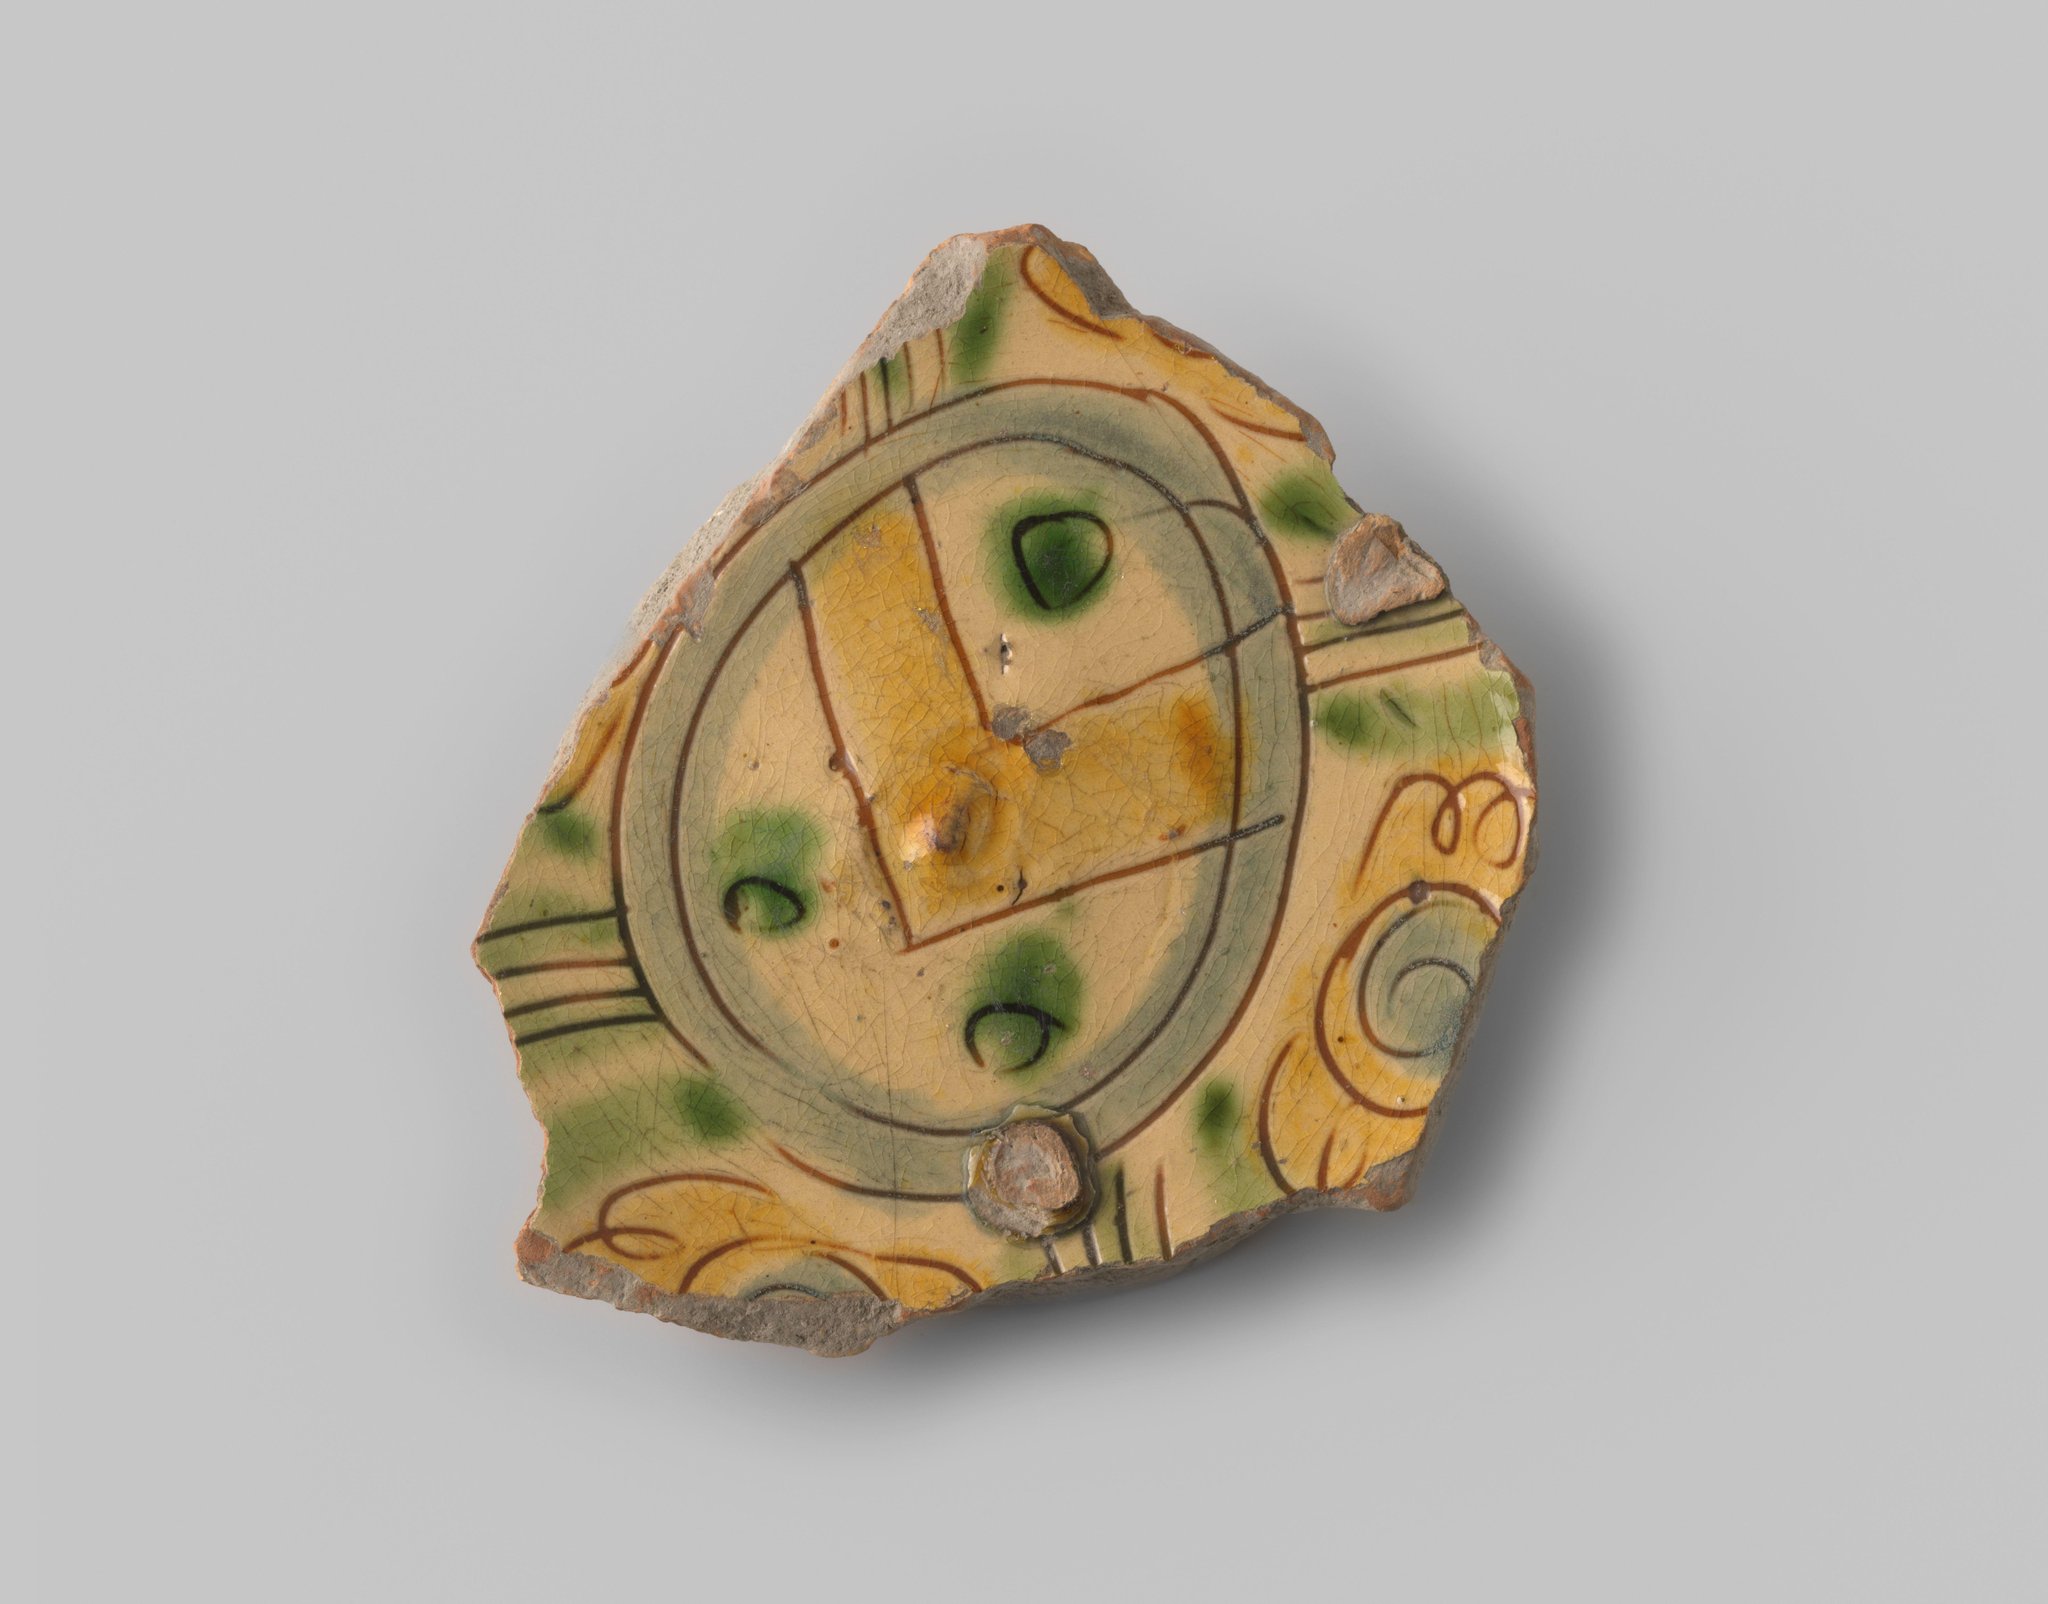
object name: sherd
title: Fragment (voet) met rode scherf, in sgraffito-techniek een eivormig wapen met een baan en drie bollen, in groen en oker, in fletsblauwe omlijsting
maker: Anonymous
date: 1200-1899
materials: earthenware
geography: italy